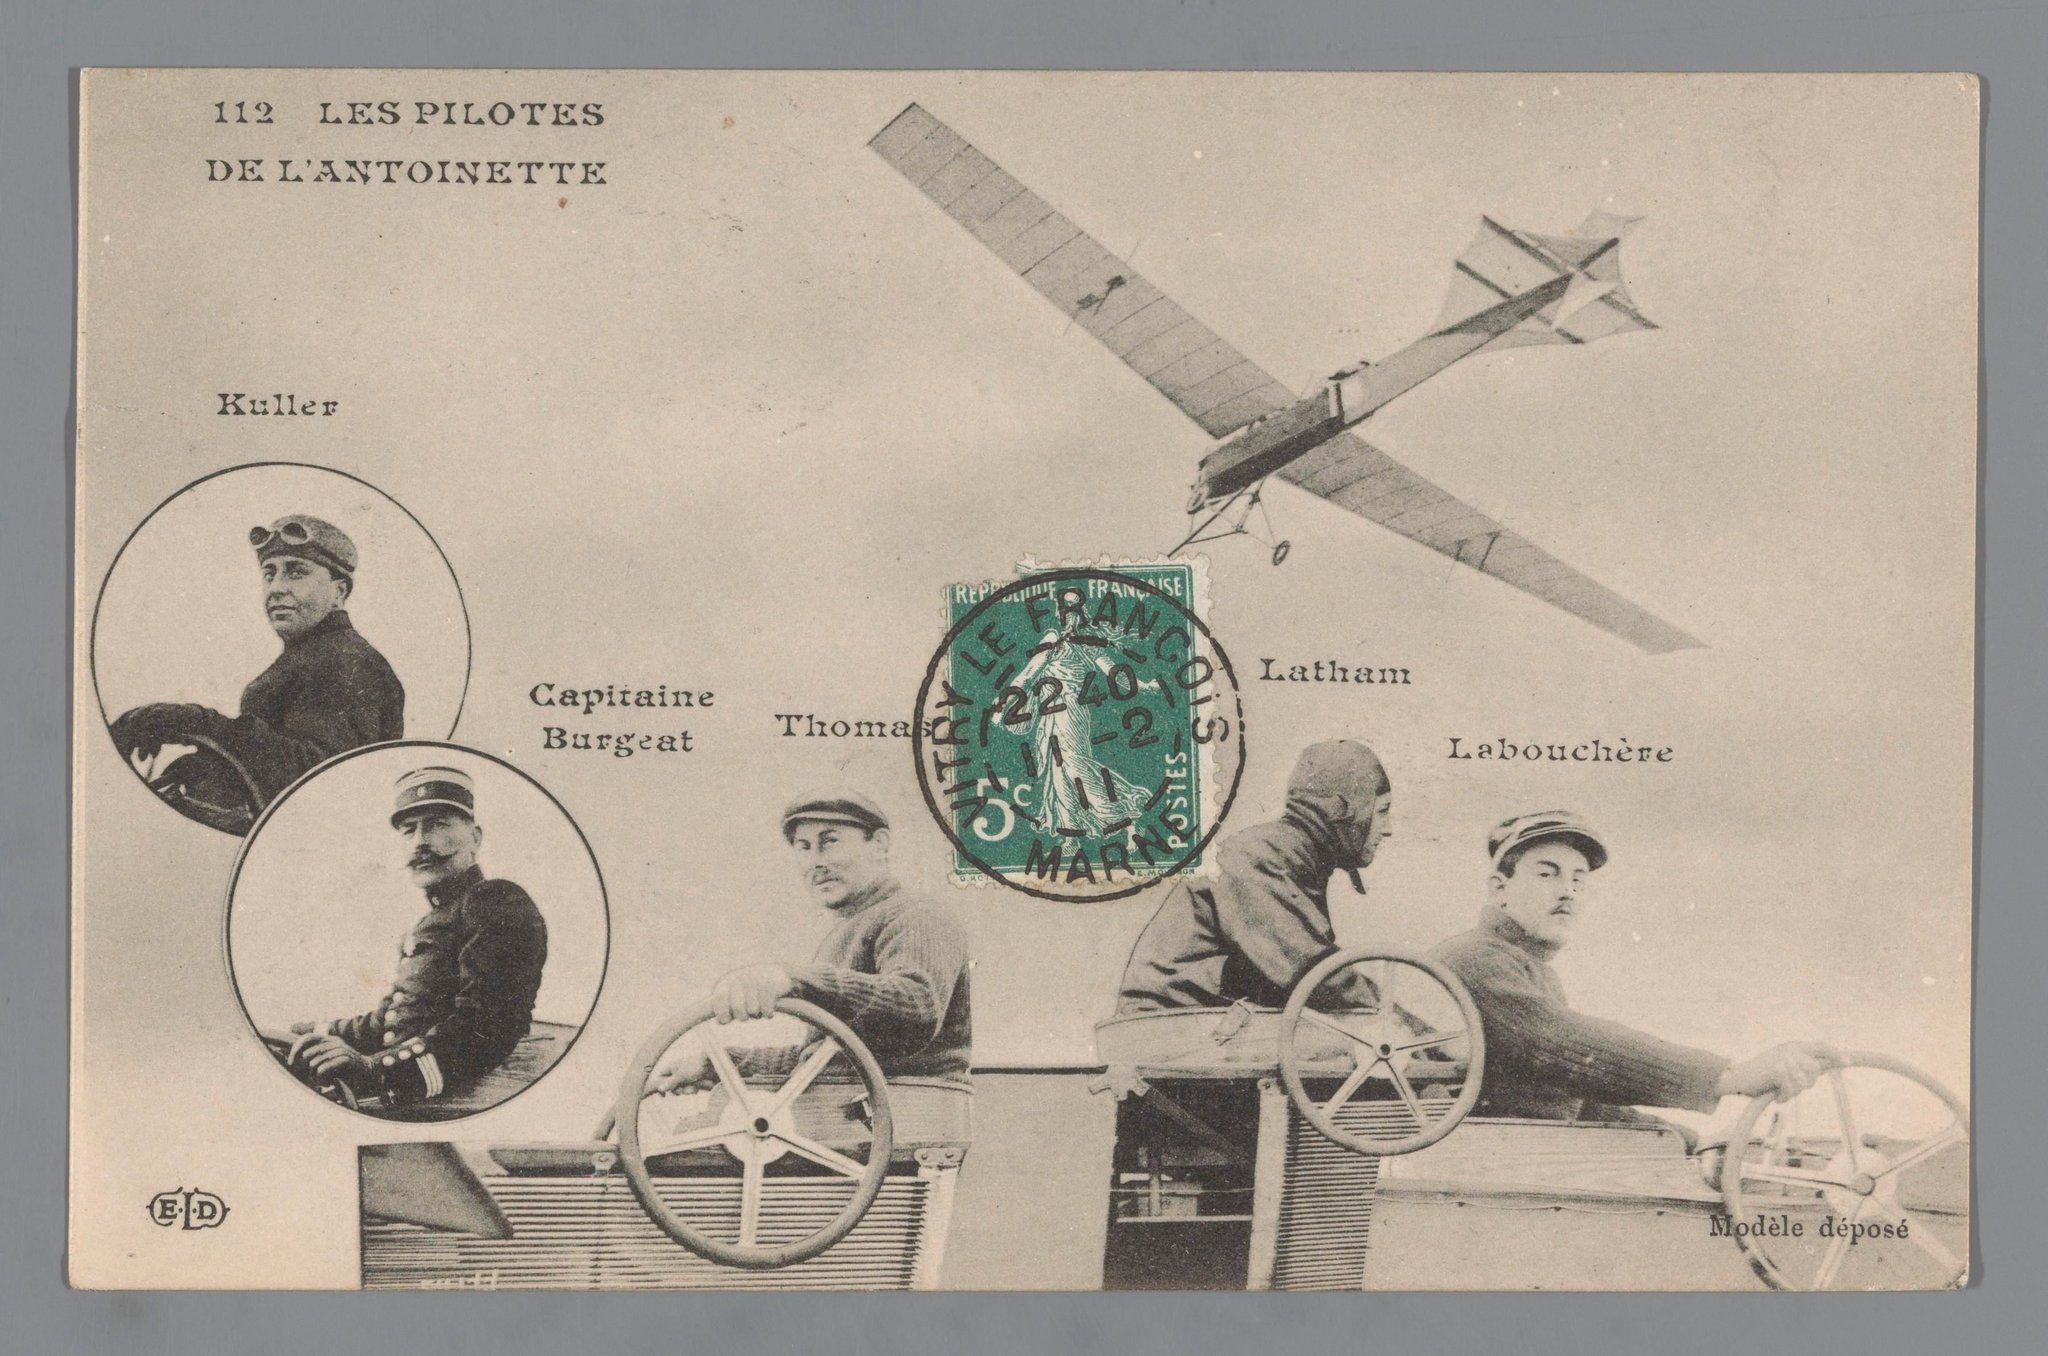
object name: ansichtkaart, prentbriefkaart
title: Les pilotes de l'Antoinette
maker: Anonymous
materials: paper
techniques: photograph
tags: aircraft, aeroplane, pilot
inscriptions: inscription: ‘Vitry le Francois Marne 2240 11-2 11’, inscription: ‘E D’, inscription: ‘G Poucelet (...) Delft (Hollande)’, number: ‘112’